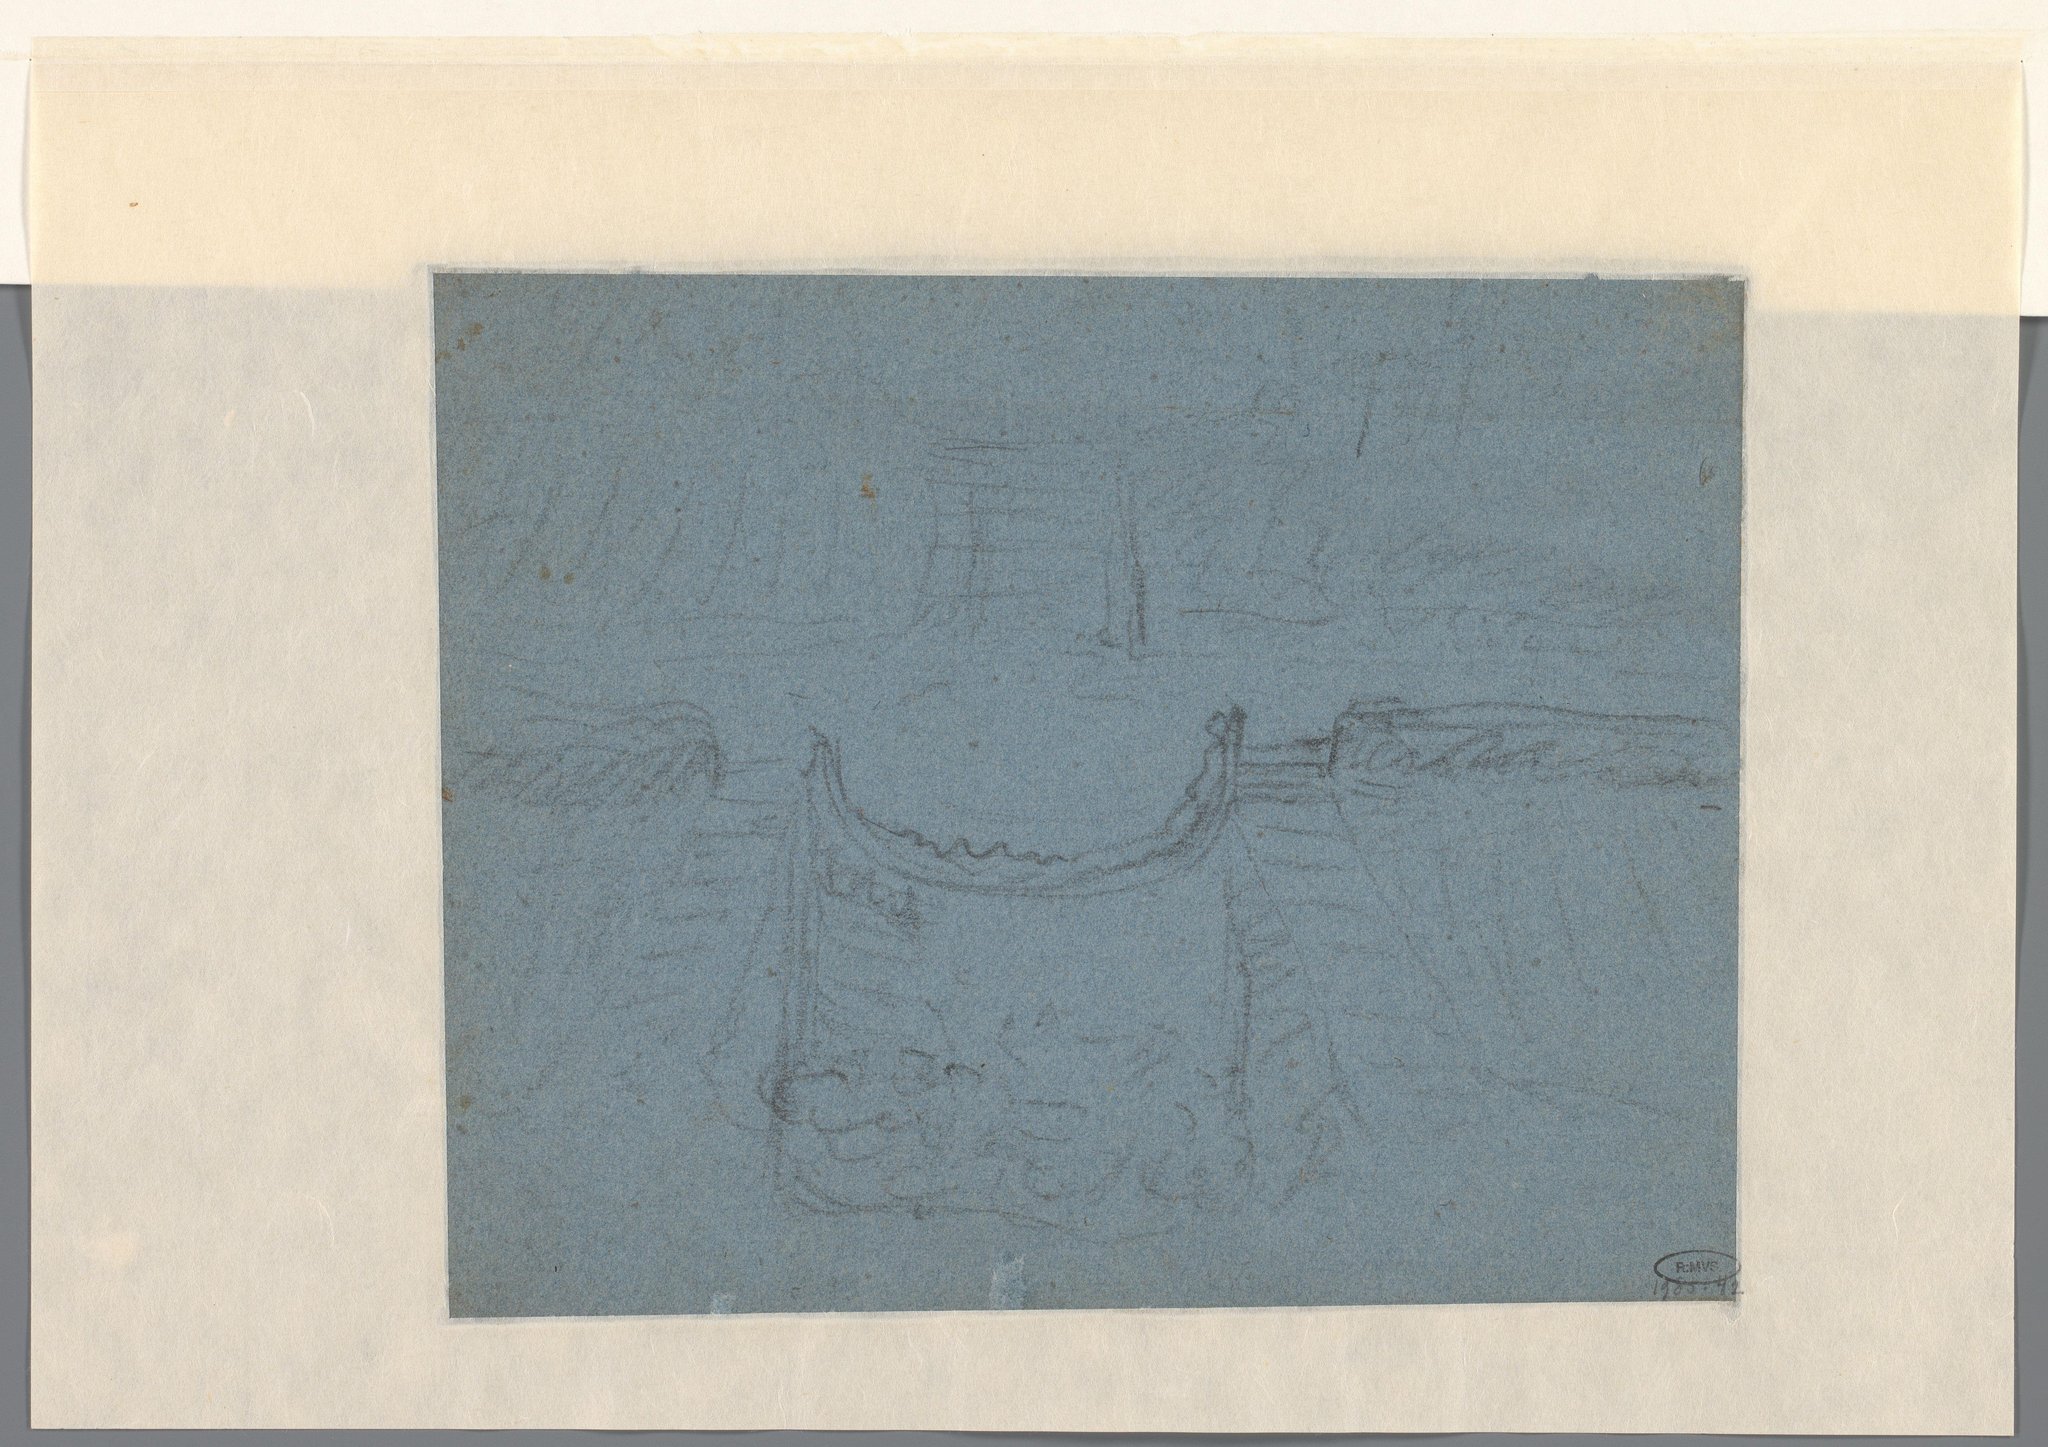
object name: drawing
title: Onherkenbare schets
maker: simon de vlieger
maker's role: draughtsman, painter, print maker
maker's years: 1600-1653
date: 1610-1653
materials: chalk, paper